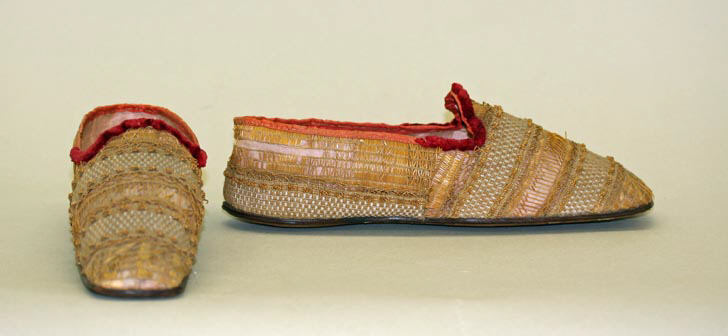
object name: shoe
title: Shoes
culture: european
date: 1835-1840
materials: fiber